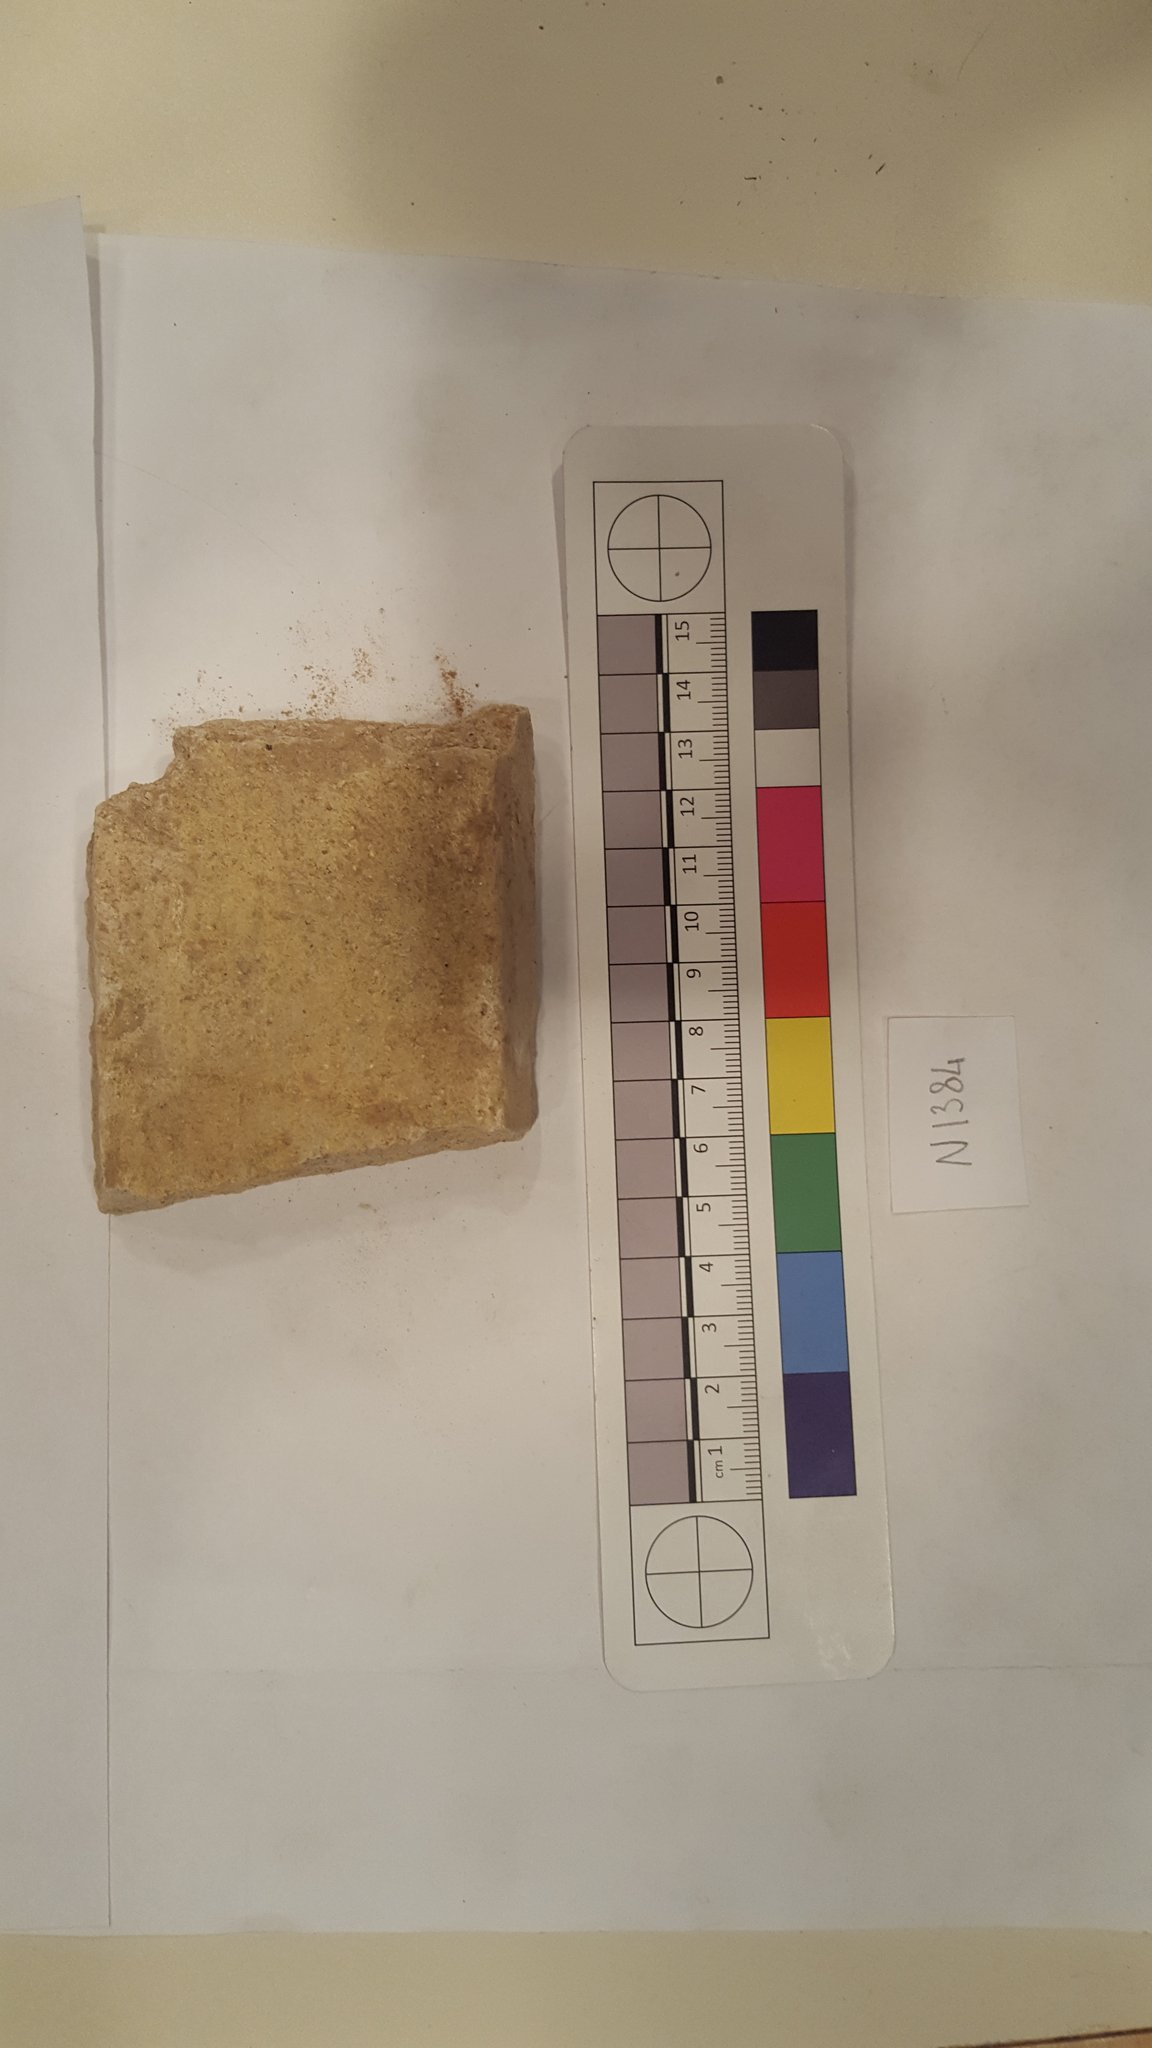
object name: fragment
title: Stucco Fragment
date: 701-1200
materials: plaster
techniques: carving, painting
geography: iran